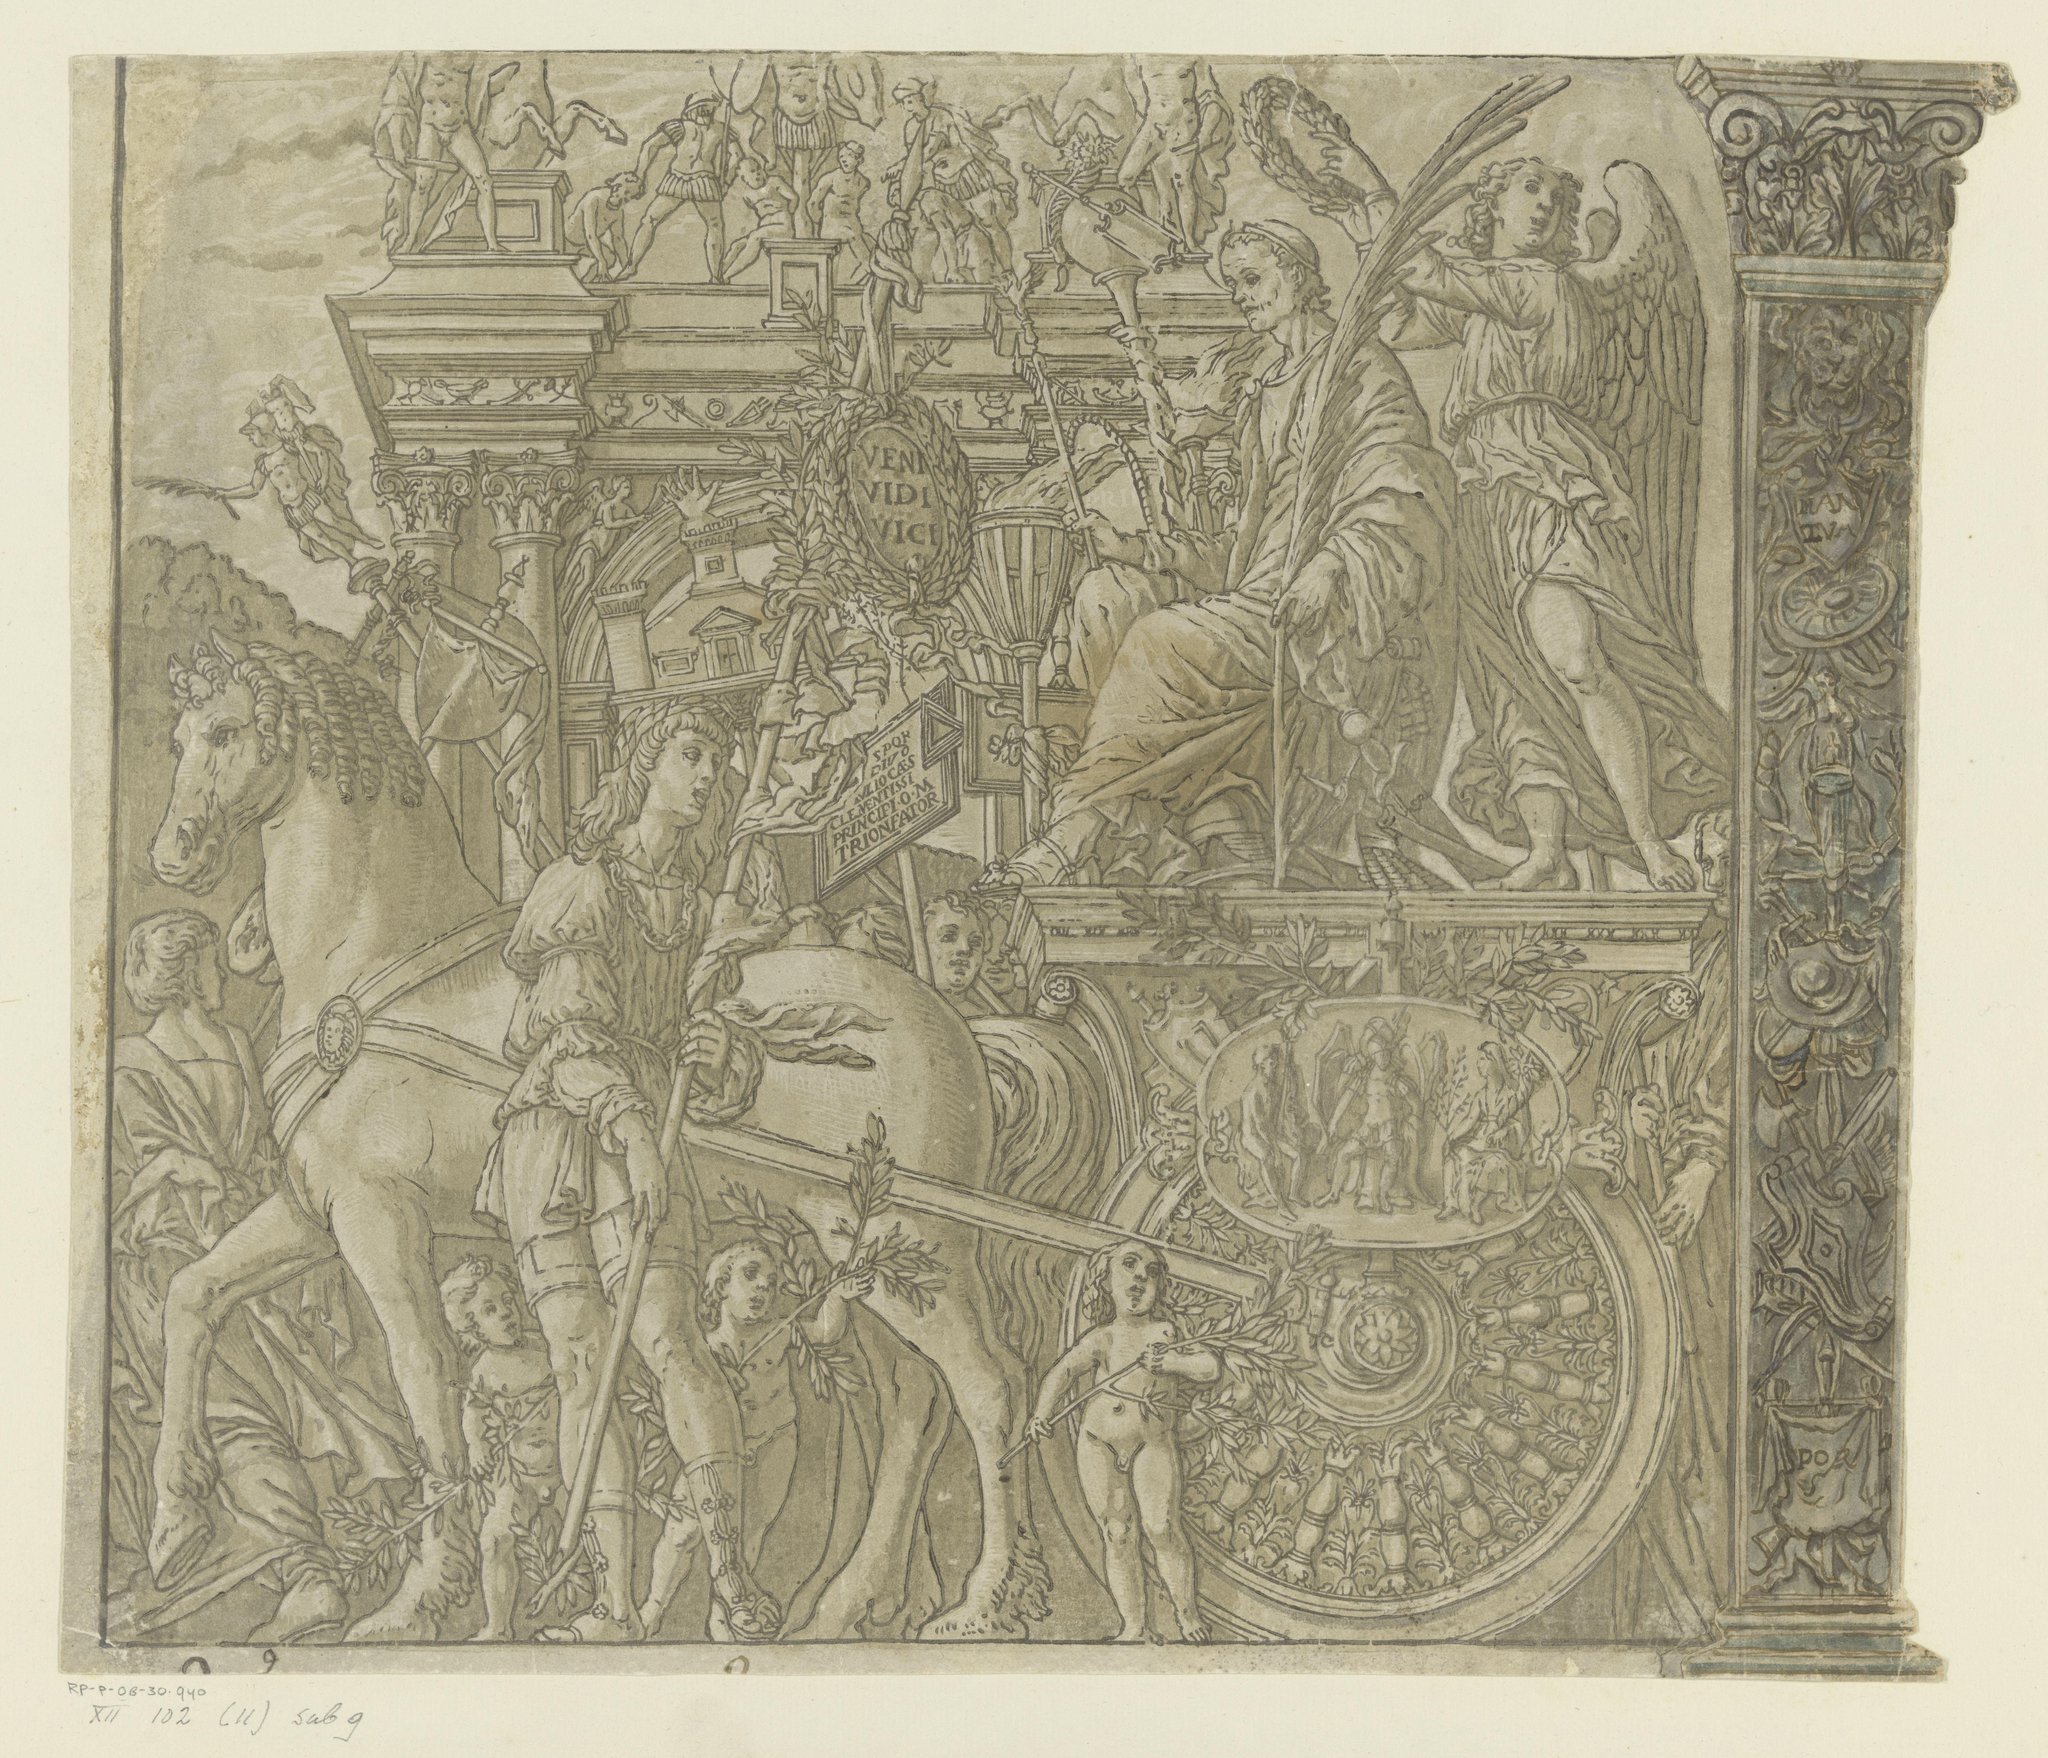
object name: print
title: Triomftocht van Julius Caesar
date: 1599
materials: ink, paper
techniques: woodcut, pen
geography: italy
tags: triumph of caesar, proverbs, sayings, etc., roman chariot, quadriga ~ triumph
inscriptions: collector's mark: Lugt 240, number: ‘9’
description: Deze prent maakt deel uit van een fries dat bestaat uit een titelprent en negen prenten die samen een triomftocht van Julius Caesar vormen. Bij de serie hoort tevens een prent met daarop zes Korinthische pilasters, bedoeld om te worden uitgeknipt en gebruikt als verbindingsstukken tussen de verschillende bladen. Op dit exemplaar is aan de rechterkant een getekende kopie naar een van de pilasters gemonteerd.